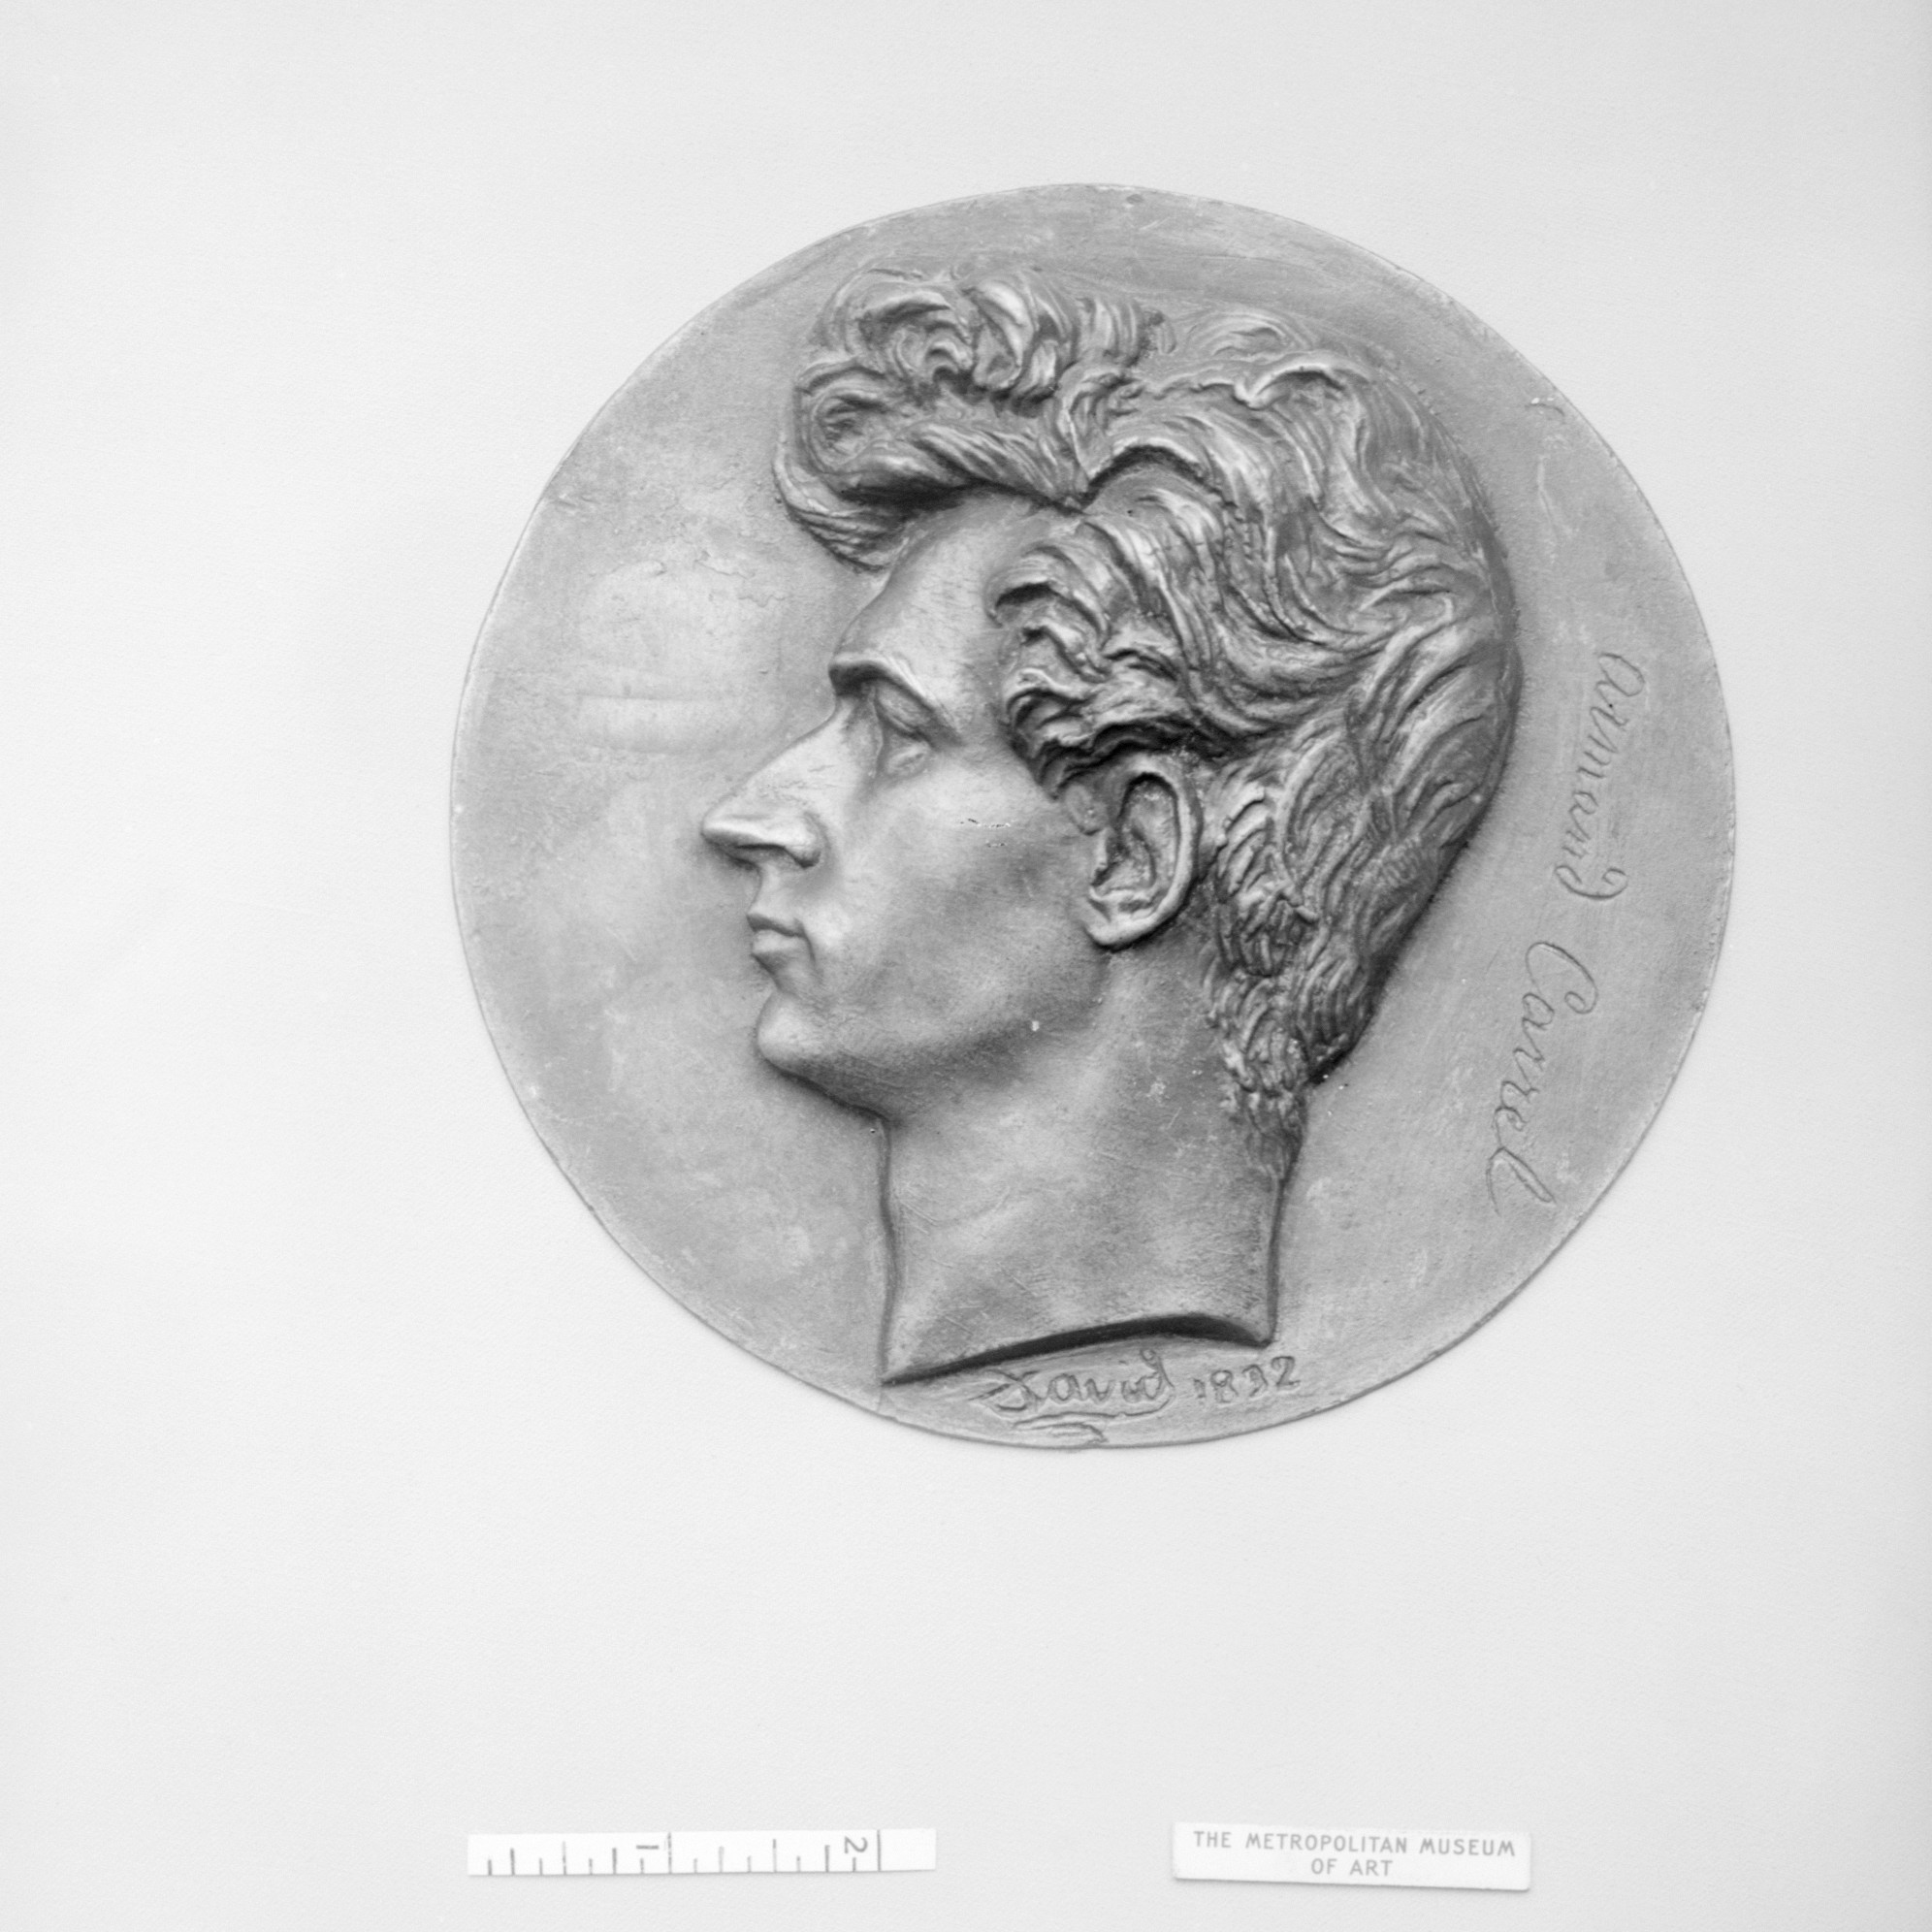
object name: medallion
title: Armand Carrel (1800–1836), French publicist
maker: pierre jean david d'angers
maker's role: artist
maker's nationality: french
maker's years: 1788-1856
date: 1832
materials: bronze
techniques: casting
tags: men,profiles